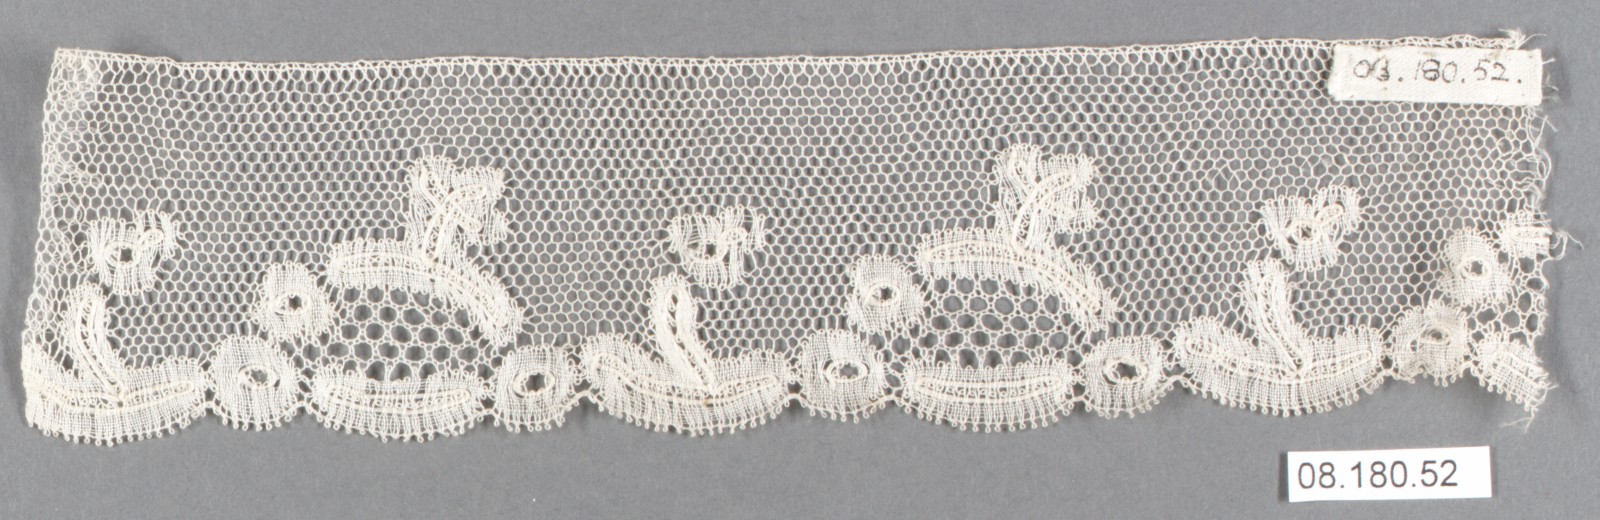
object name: fragment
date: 1801-1900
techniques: lace